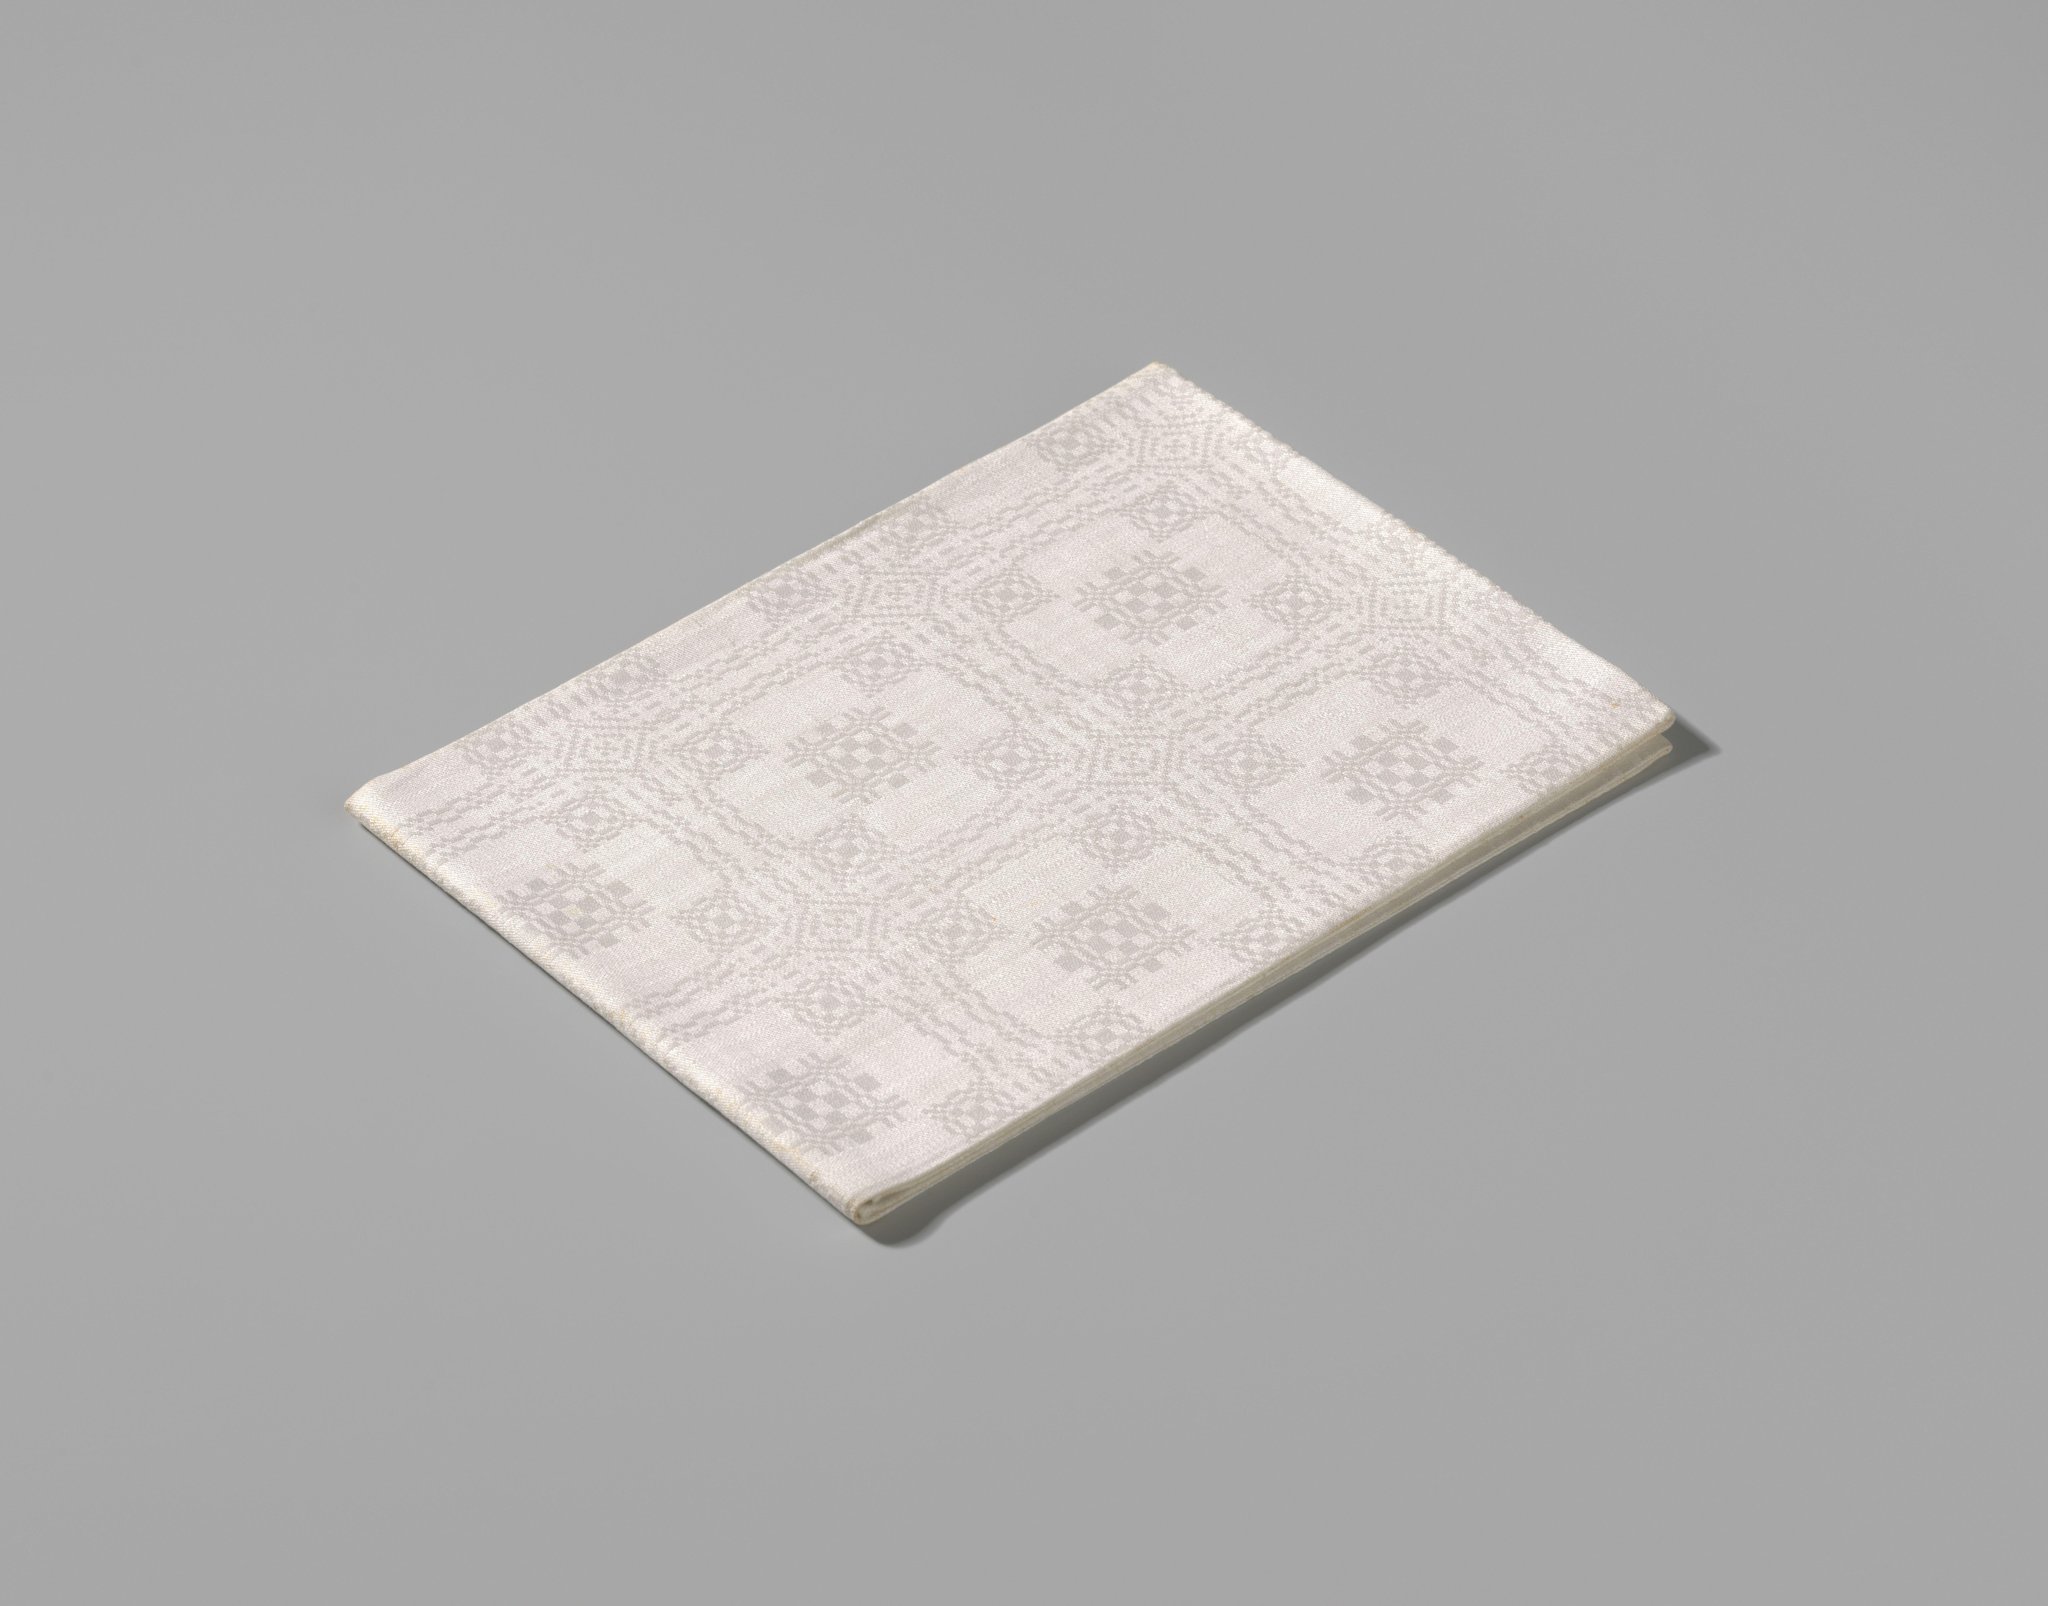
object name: towel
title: Handdoek van wit linnen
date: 1690-1710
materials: linen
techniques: peeled fabric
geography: netherlands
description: Wit linnen handdoek met een pellen patroon, merk IGS 37 WH 2oonl.